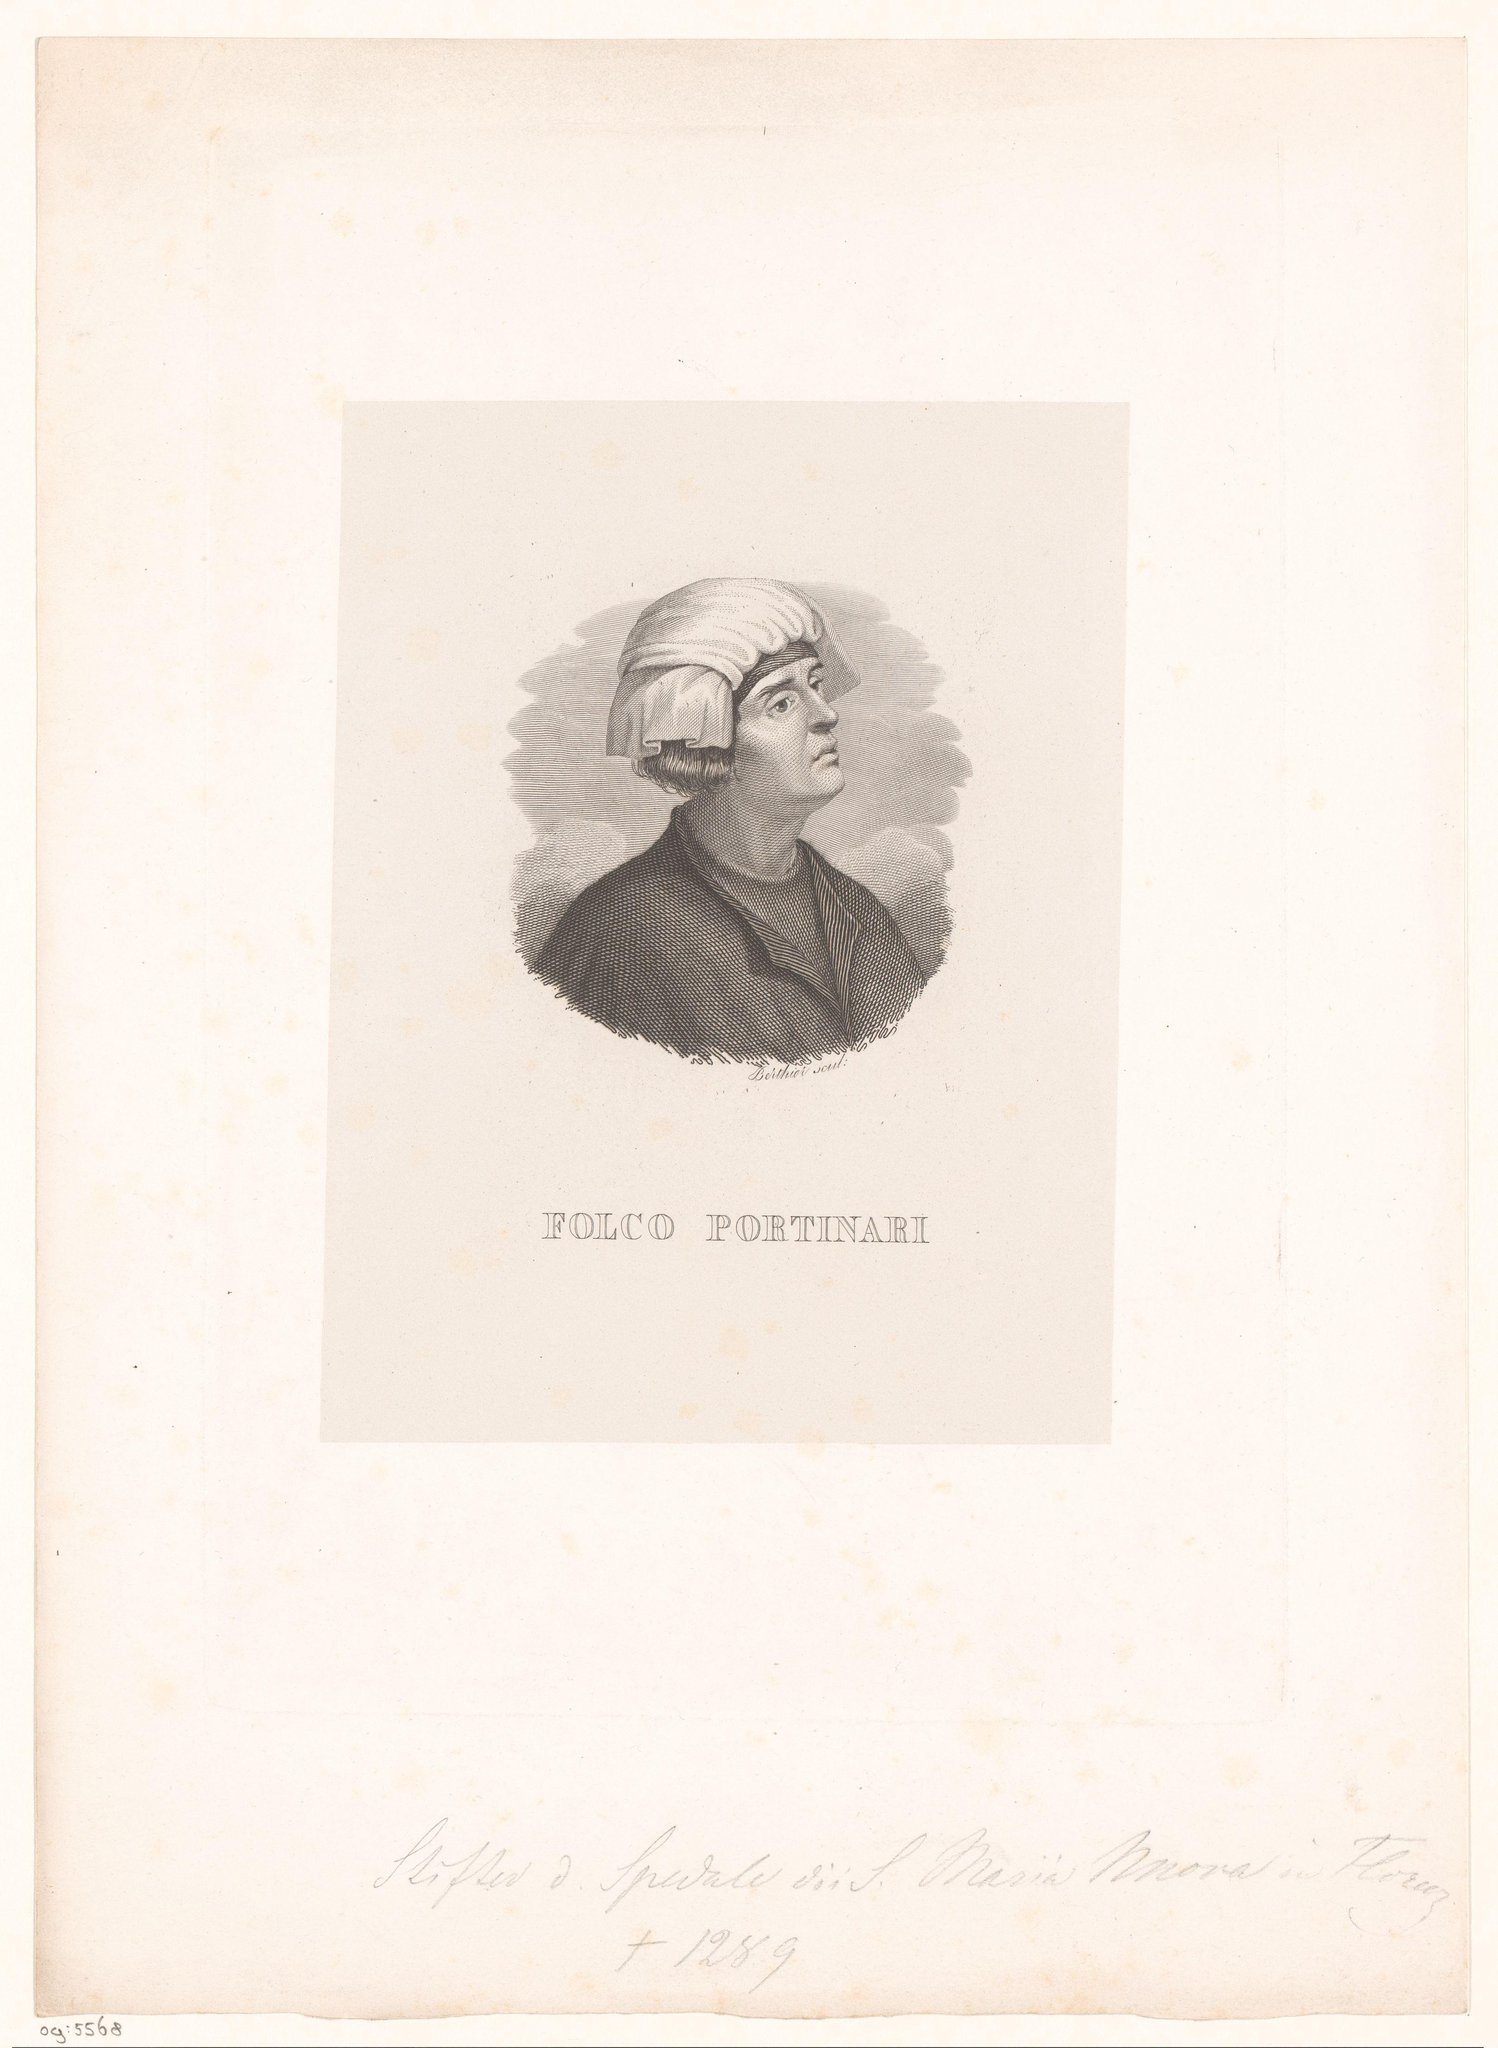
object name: print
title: Portret van Folco Portinari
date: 1741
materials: paper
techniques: engraving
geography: france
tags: historical persons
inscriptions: collector's mark: Lugt 2228